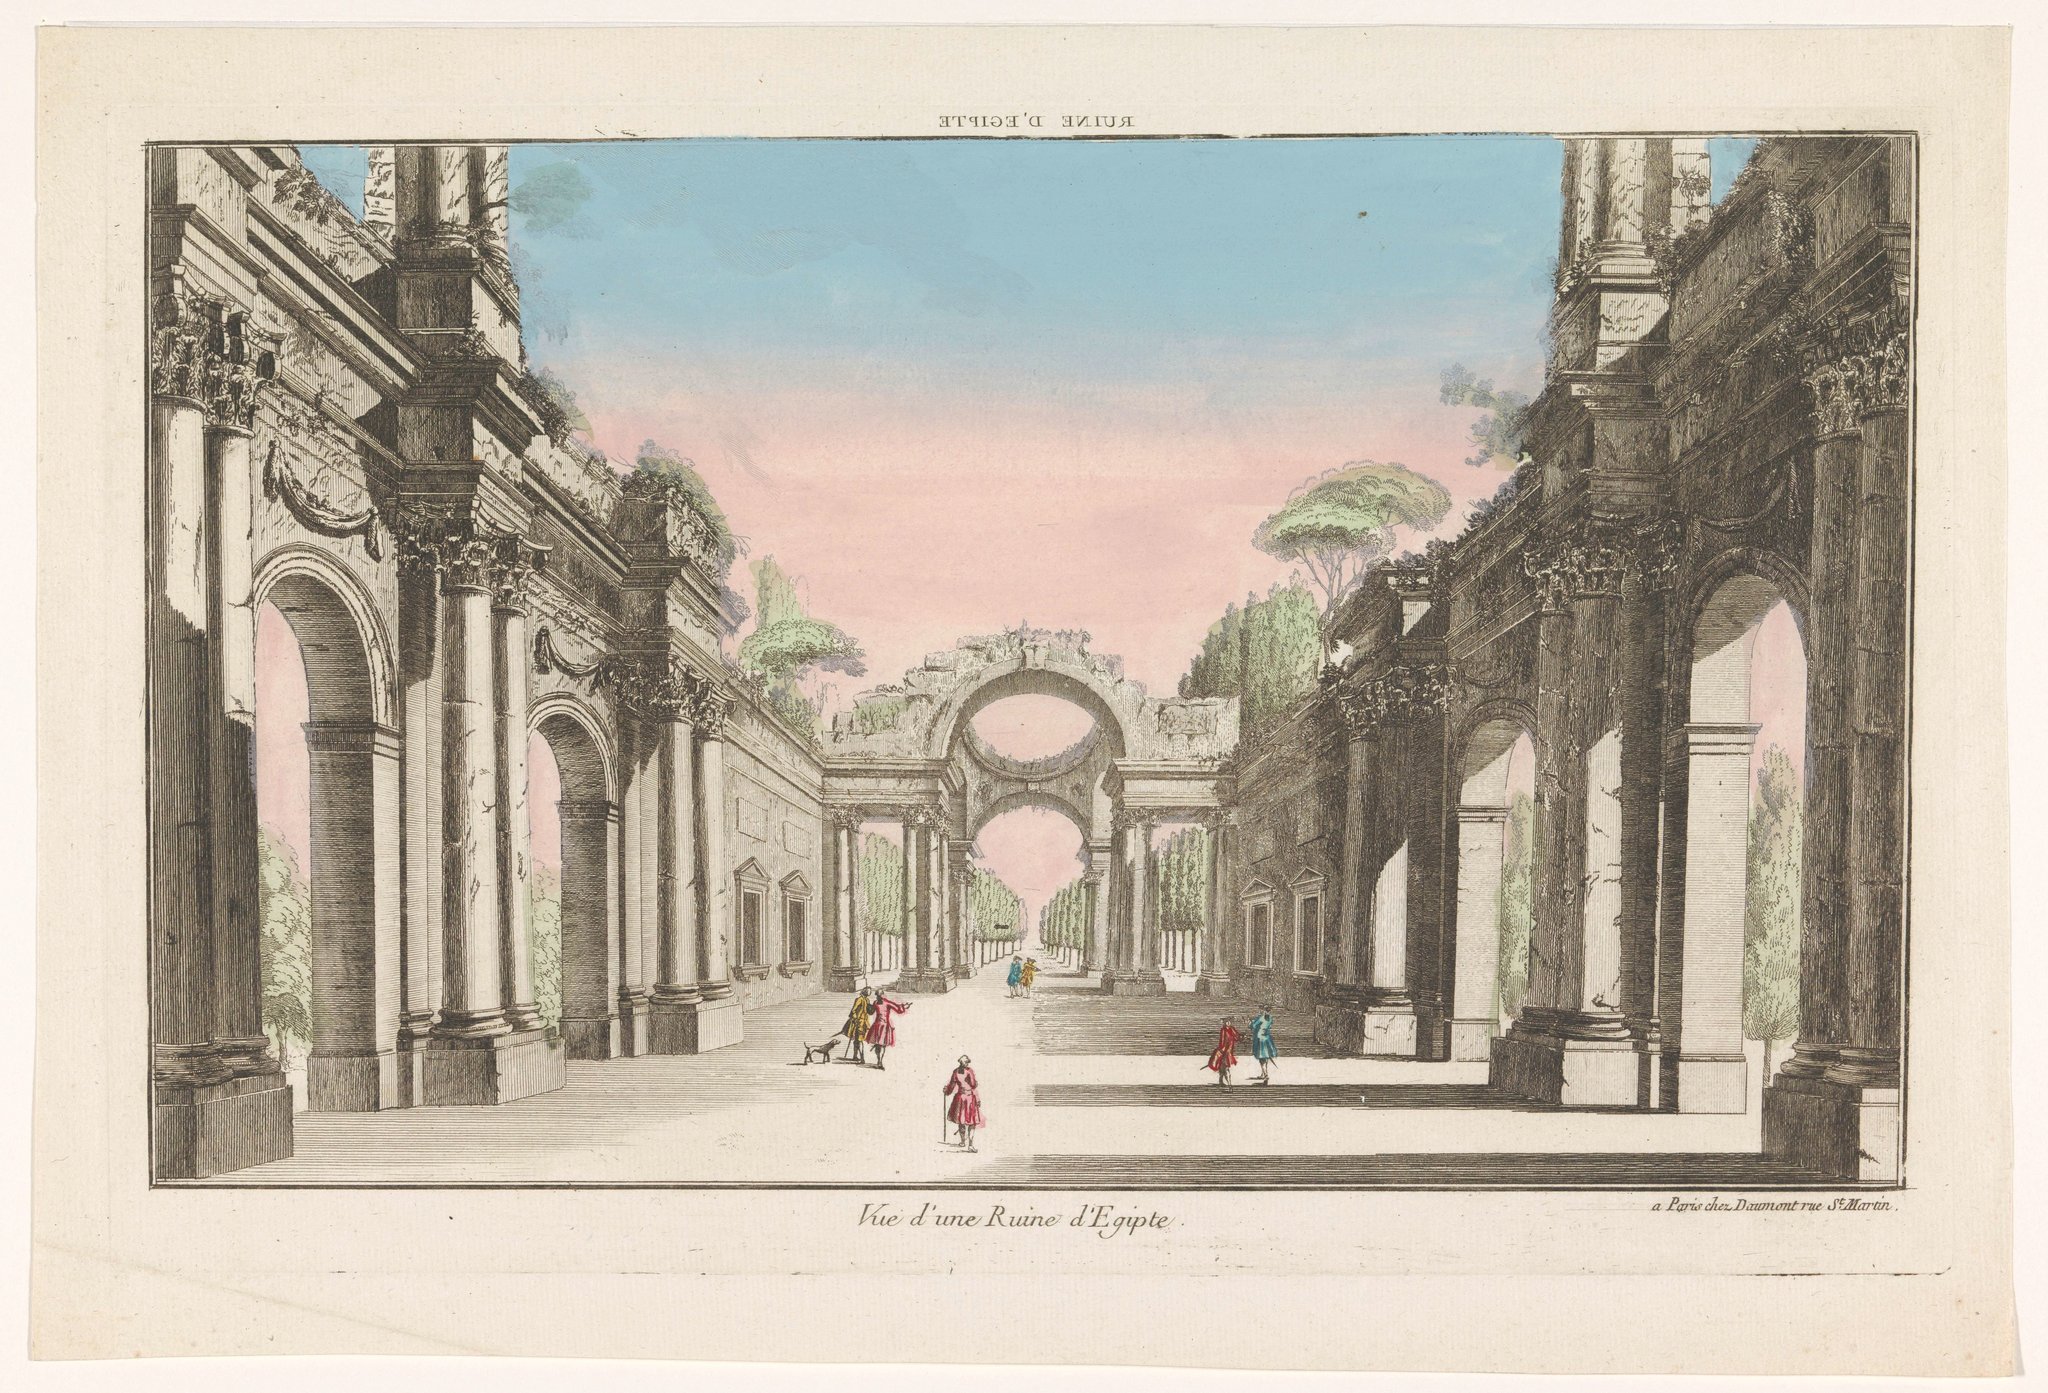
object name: opticaprent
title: Gezicht op een ruïne te Egypte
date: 1745-1775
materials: paper, watercolor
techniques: brush, etching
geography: paris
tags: landscape with ruins (+ city(-scape) with figures, staffage)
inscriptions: watermark, collector's mark: Lugt 2233